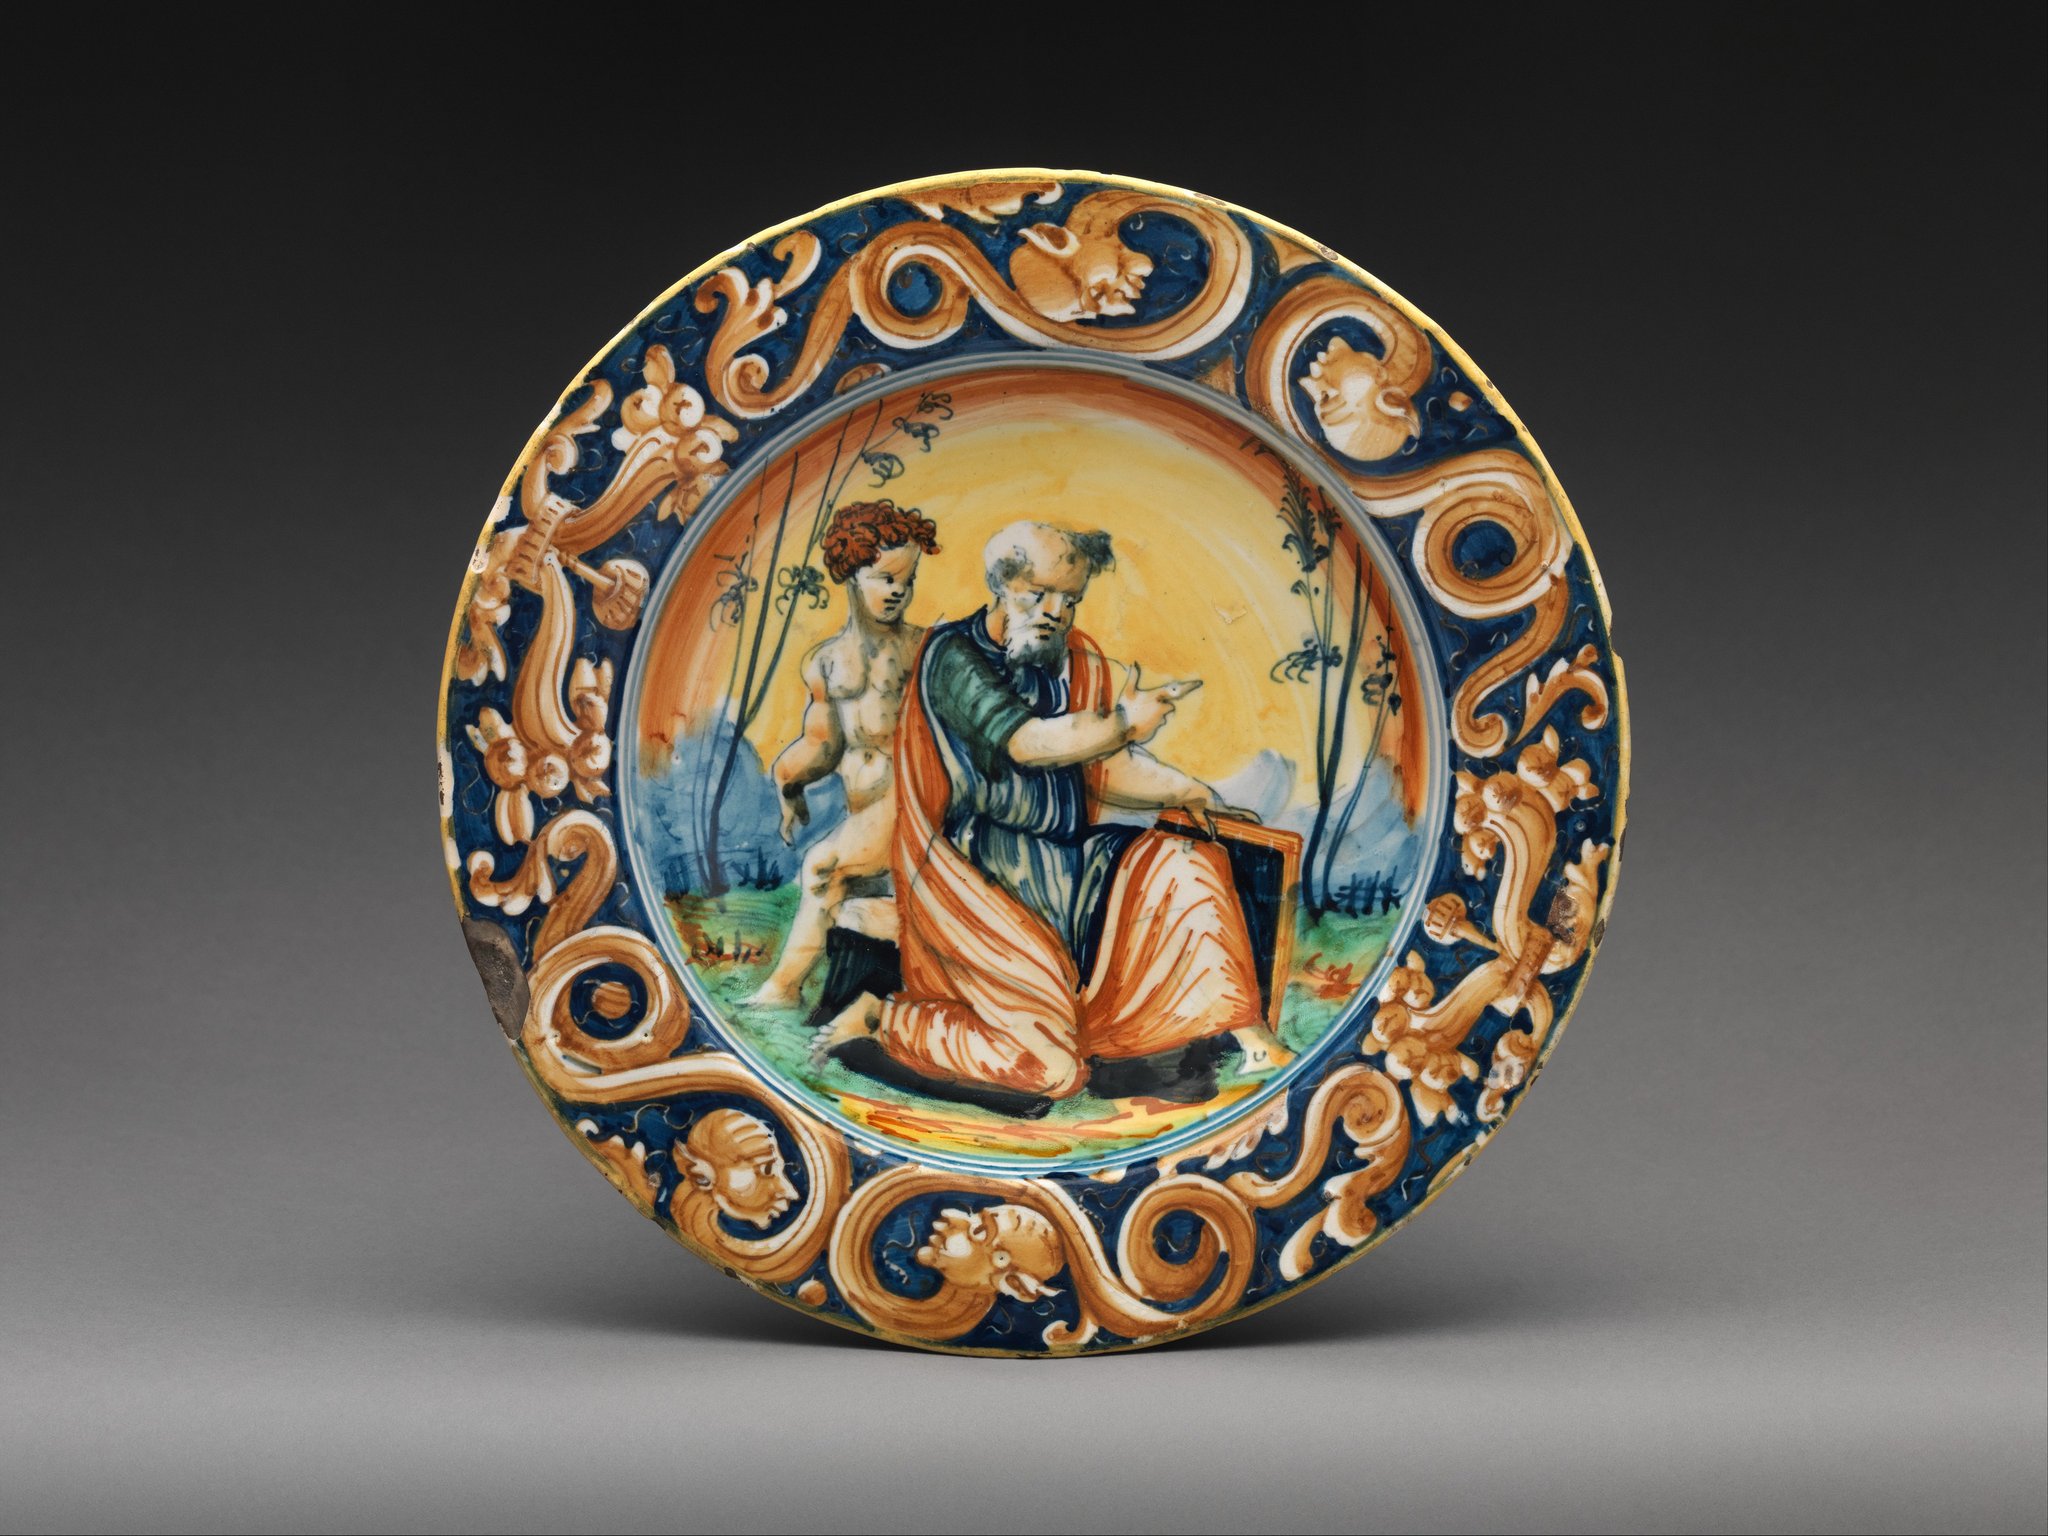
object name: plate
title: Plate with Saint Matthew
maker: workshop of ludovico and angelo picchi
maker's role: artist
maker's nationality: italian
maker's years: 1500-1599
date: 1550-1560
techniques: maiolica, glazing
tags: male nudes,saint matthew